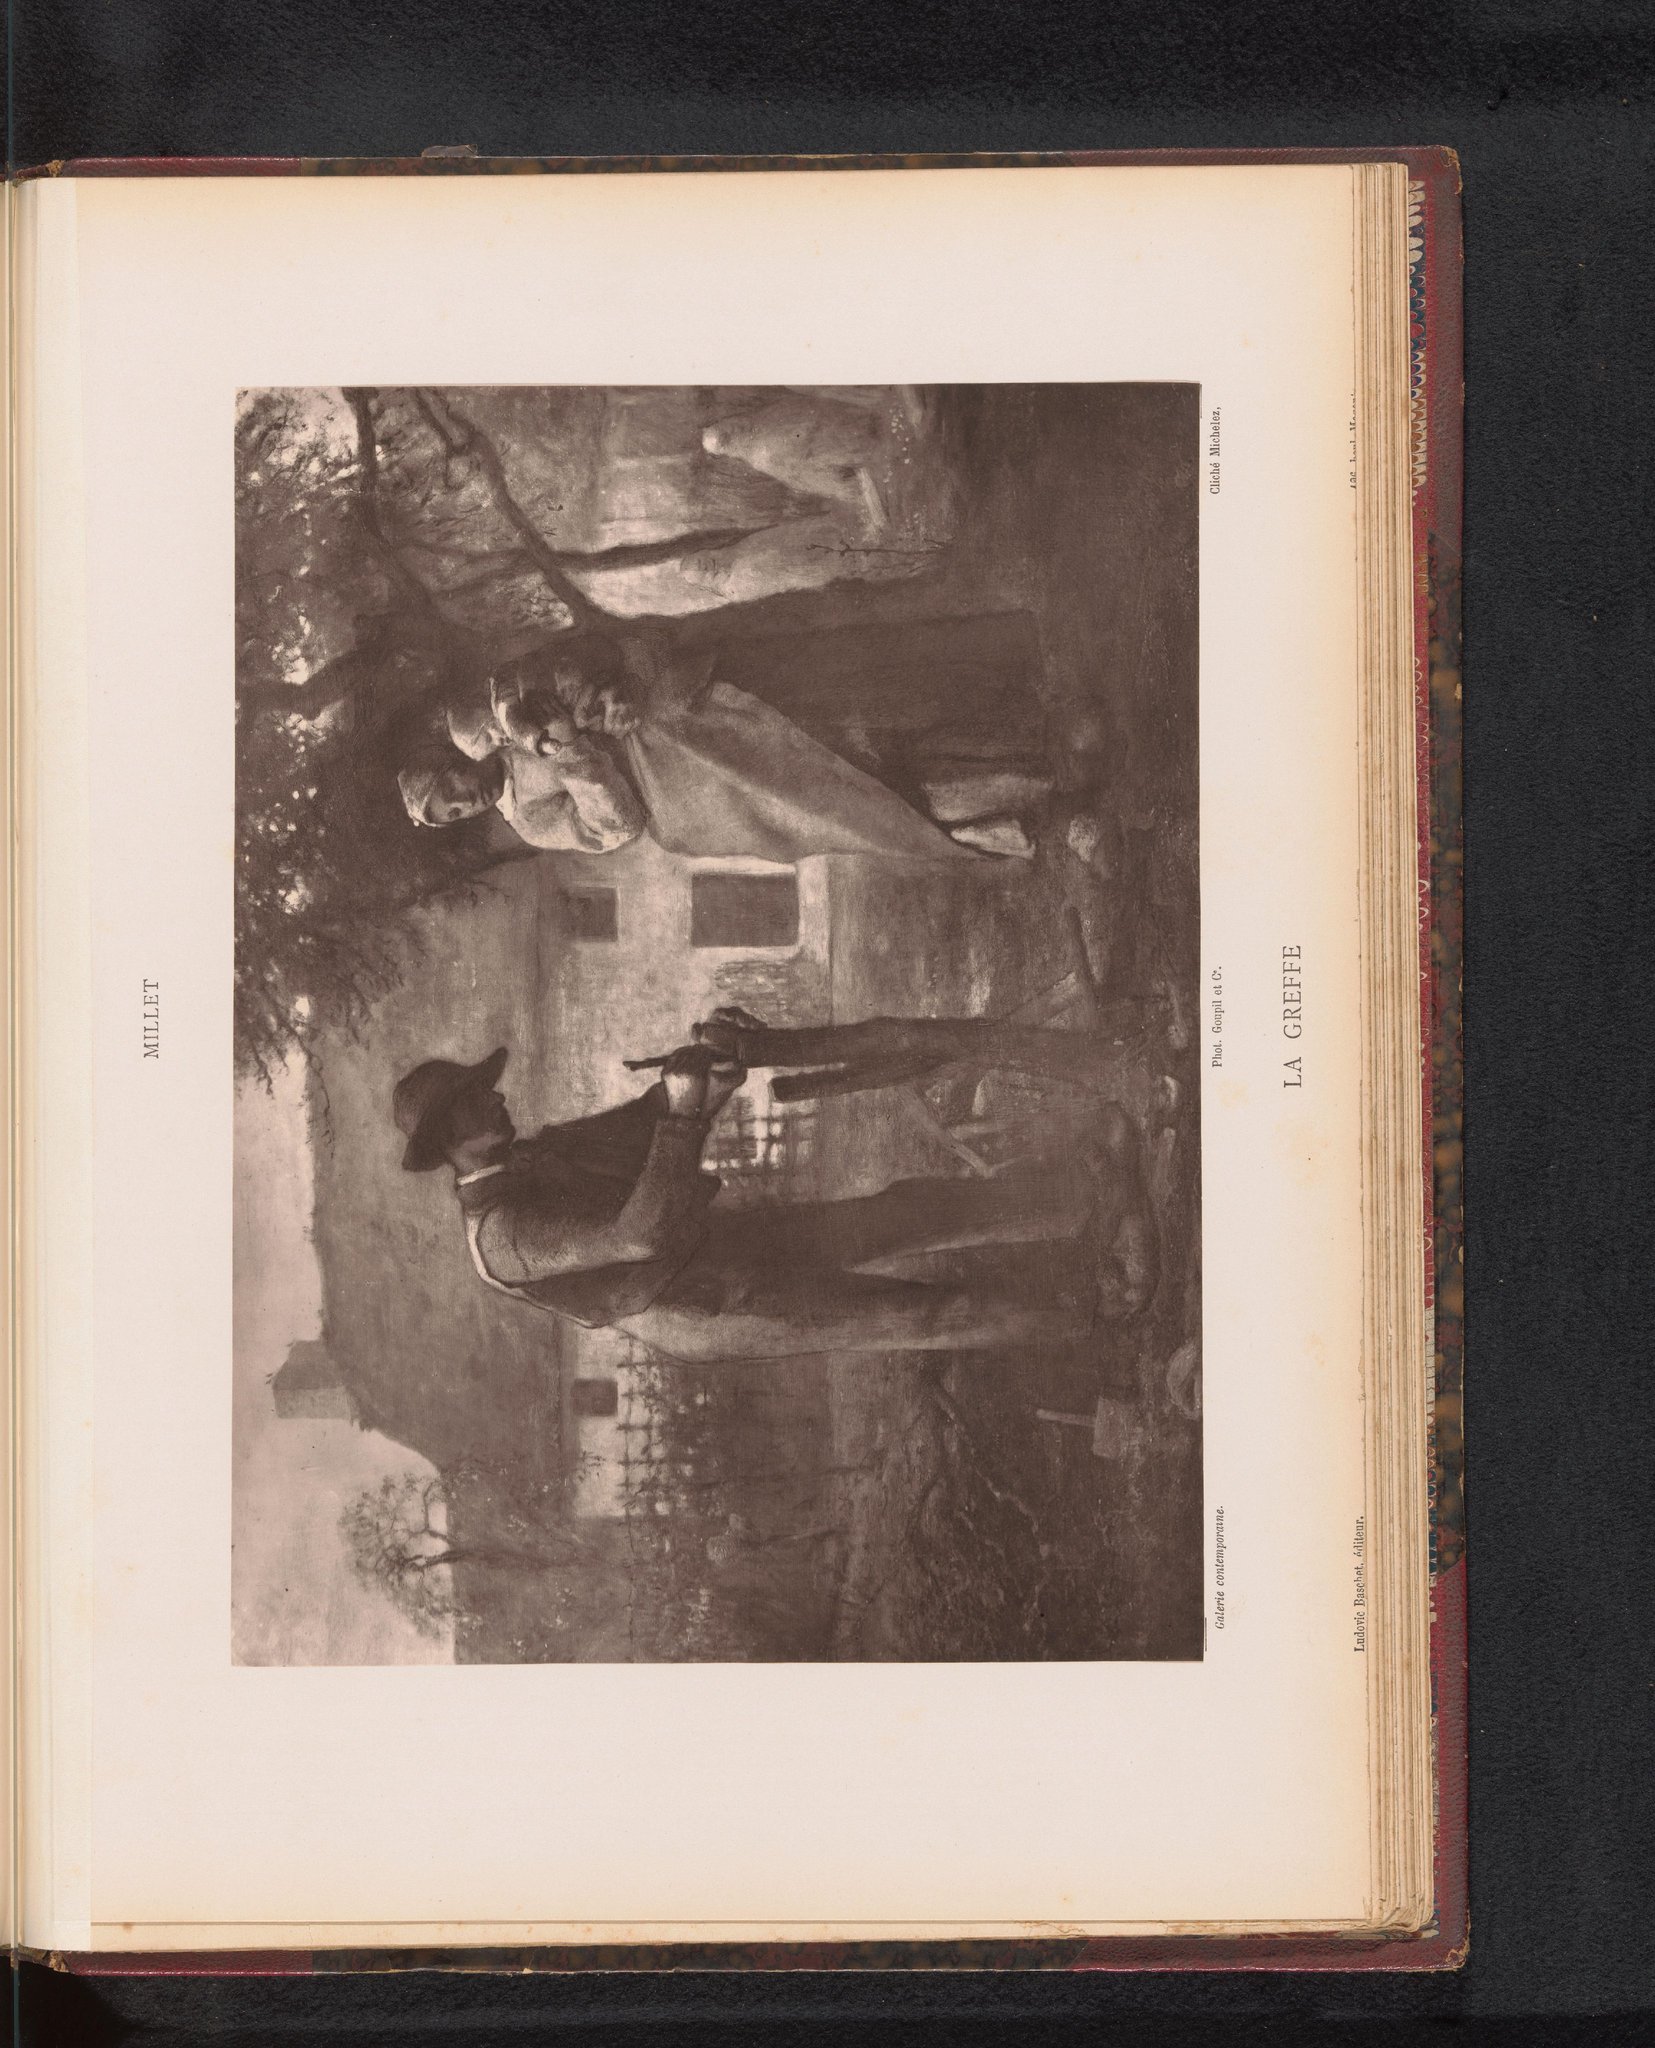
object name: reproduction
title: La greffe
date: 1873-1878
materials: paper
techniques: woodburytype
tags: parents with their children, civic architecture; edifices; dwellings, painting, drawing and the graphic arts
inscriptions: inscription: ‘Millet/ Galerie Contemporaine/ Ludovic Baschet, éditeur.’